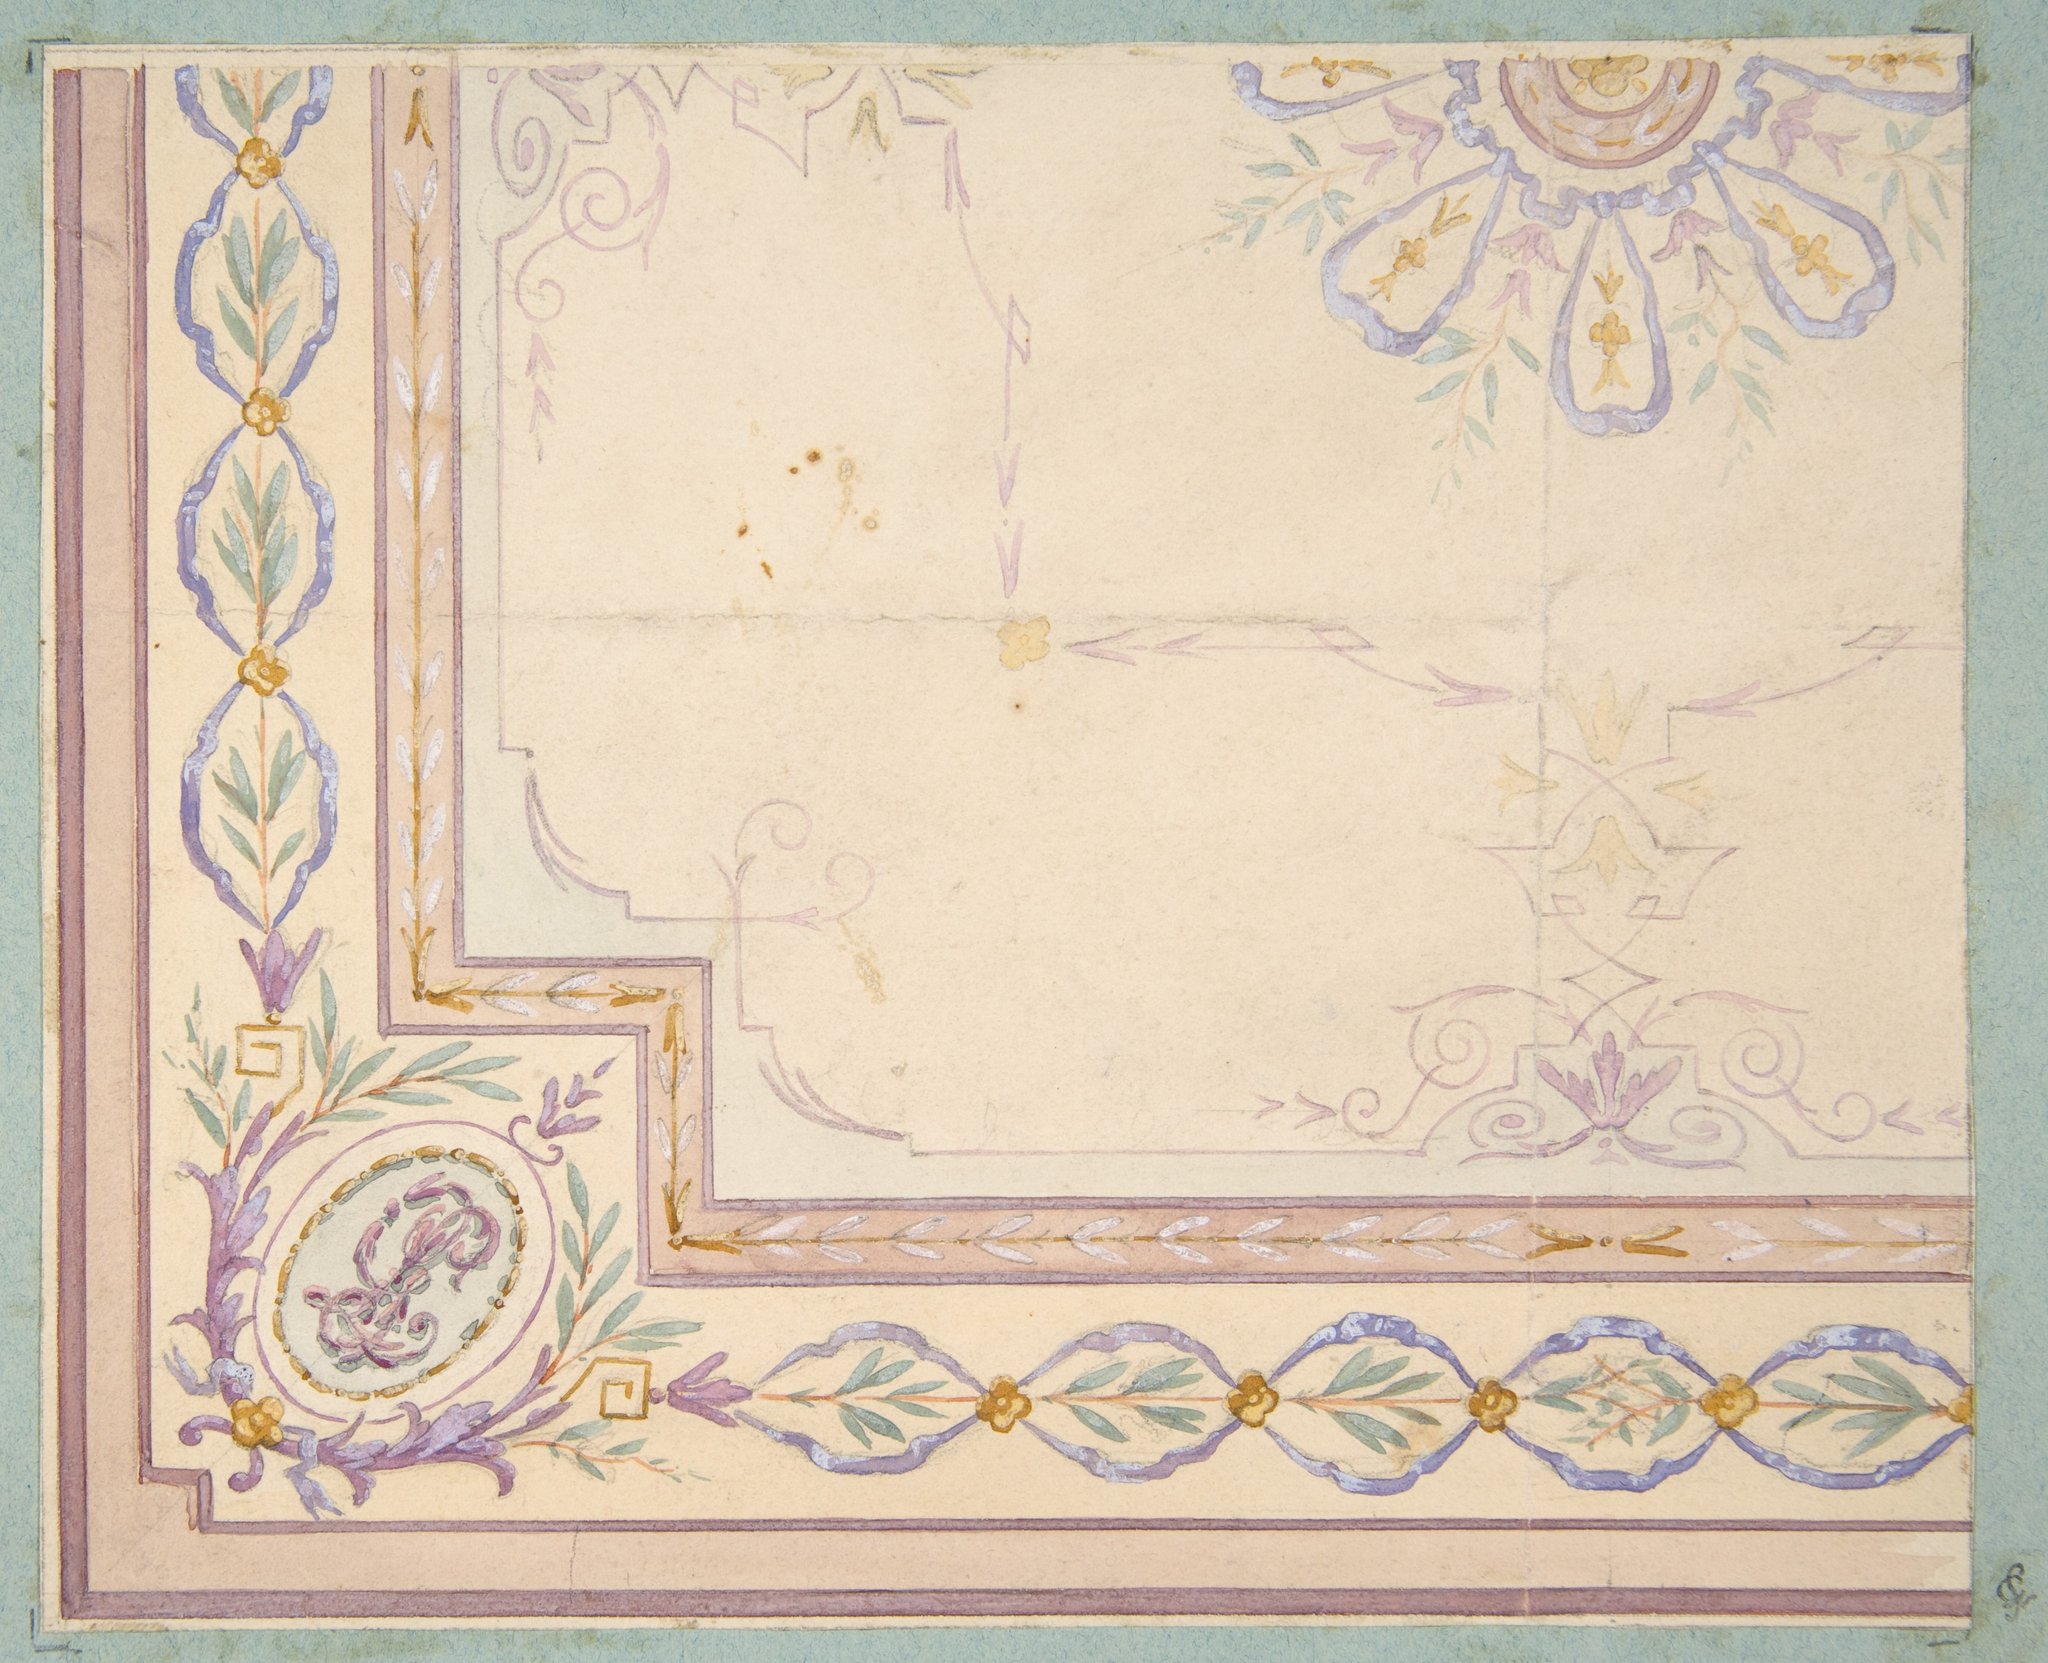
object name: drawing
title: Design for a ceiling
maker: jules-edmond-charles lachaise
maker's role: artist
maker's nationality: french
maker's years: 1897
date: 1851-1900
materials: gouache, graphite, watercolor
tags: ceilings